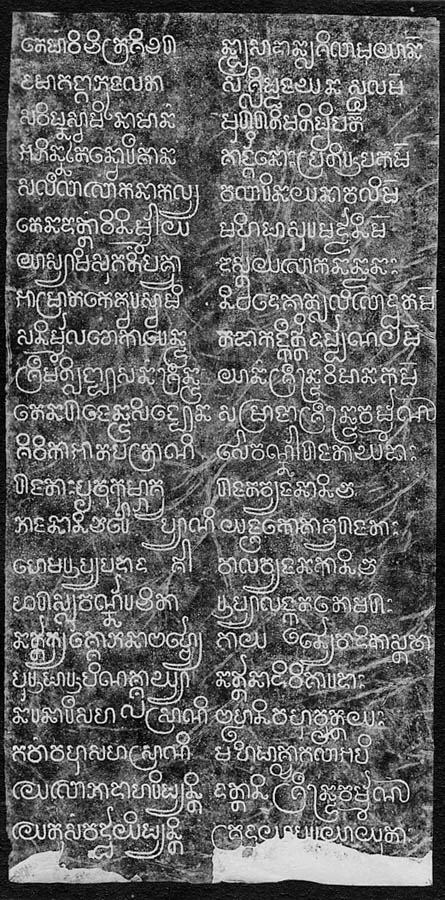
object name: rubbing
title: Rubbing of an Inscription of Bakong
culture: cambodian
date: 1901-2000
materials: ink, paper